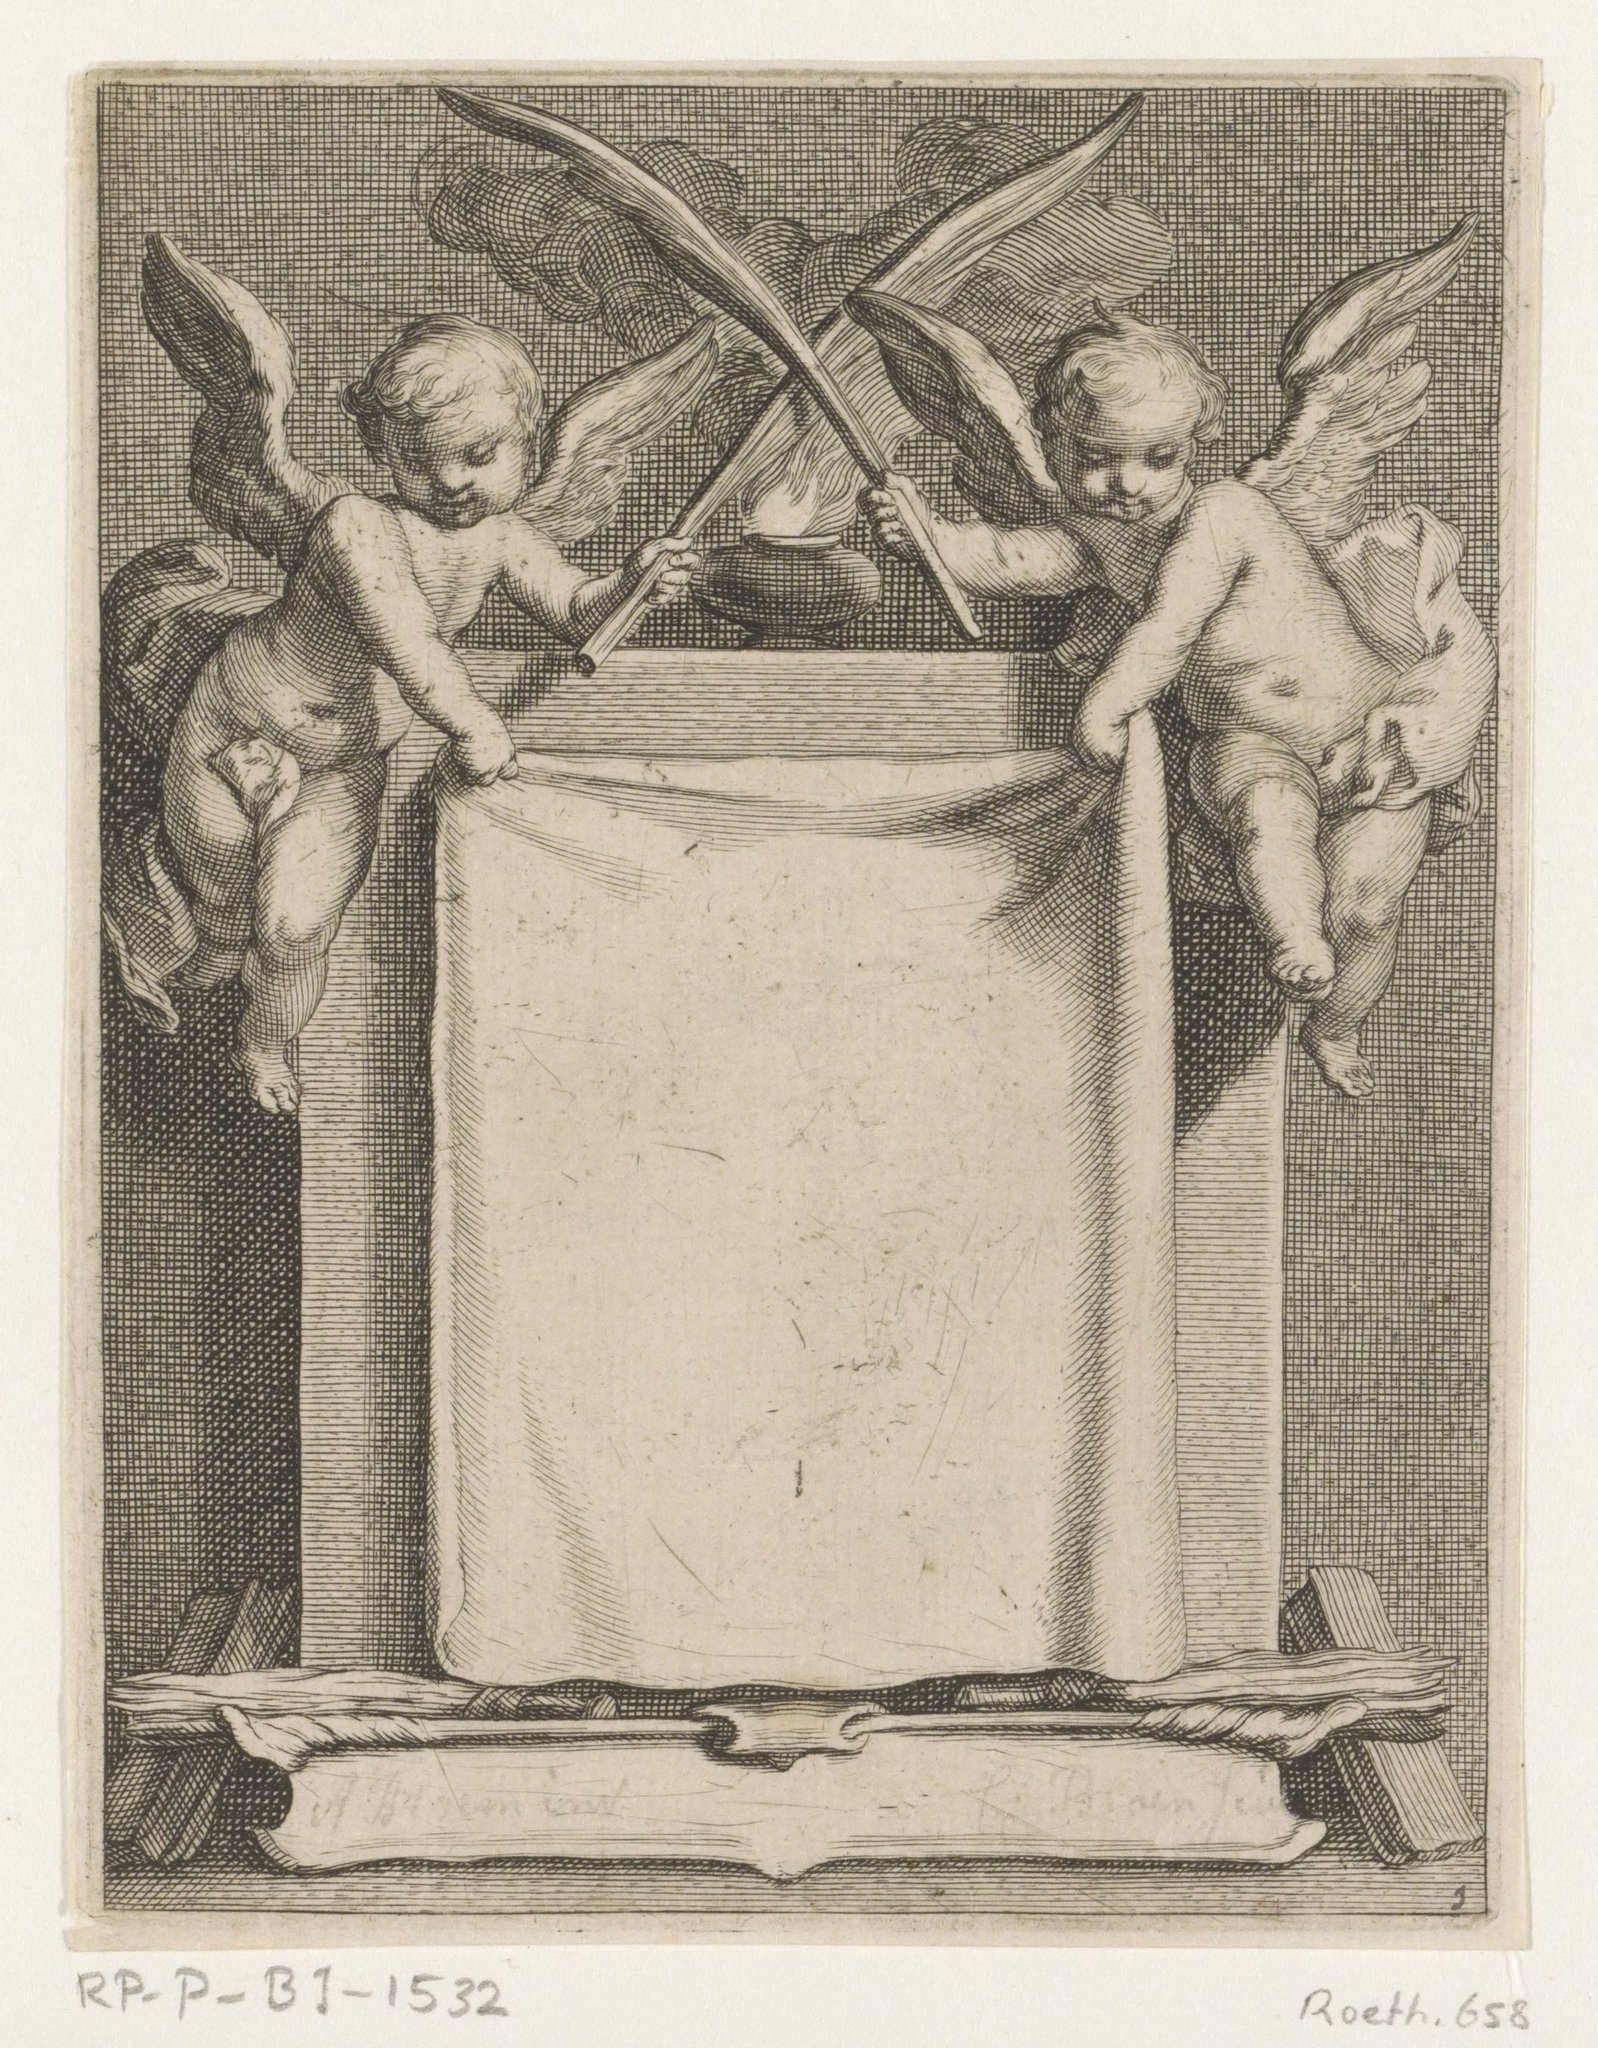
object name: print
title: Titelprent met cherubijnen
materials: paper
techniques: engraving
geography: utrecht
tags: cherubs, i.e. children's heads with wings, title-page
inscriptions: collector's mark: Lugt 240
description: Twee cherubijnen houden een doek vast waarop een tekst ontbreekt.